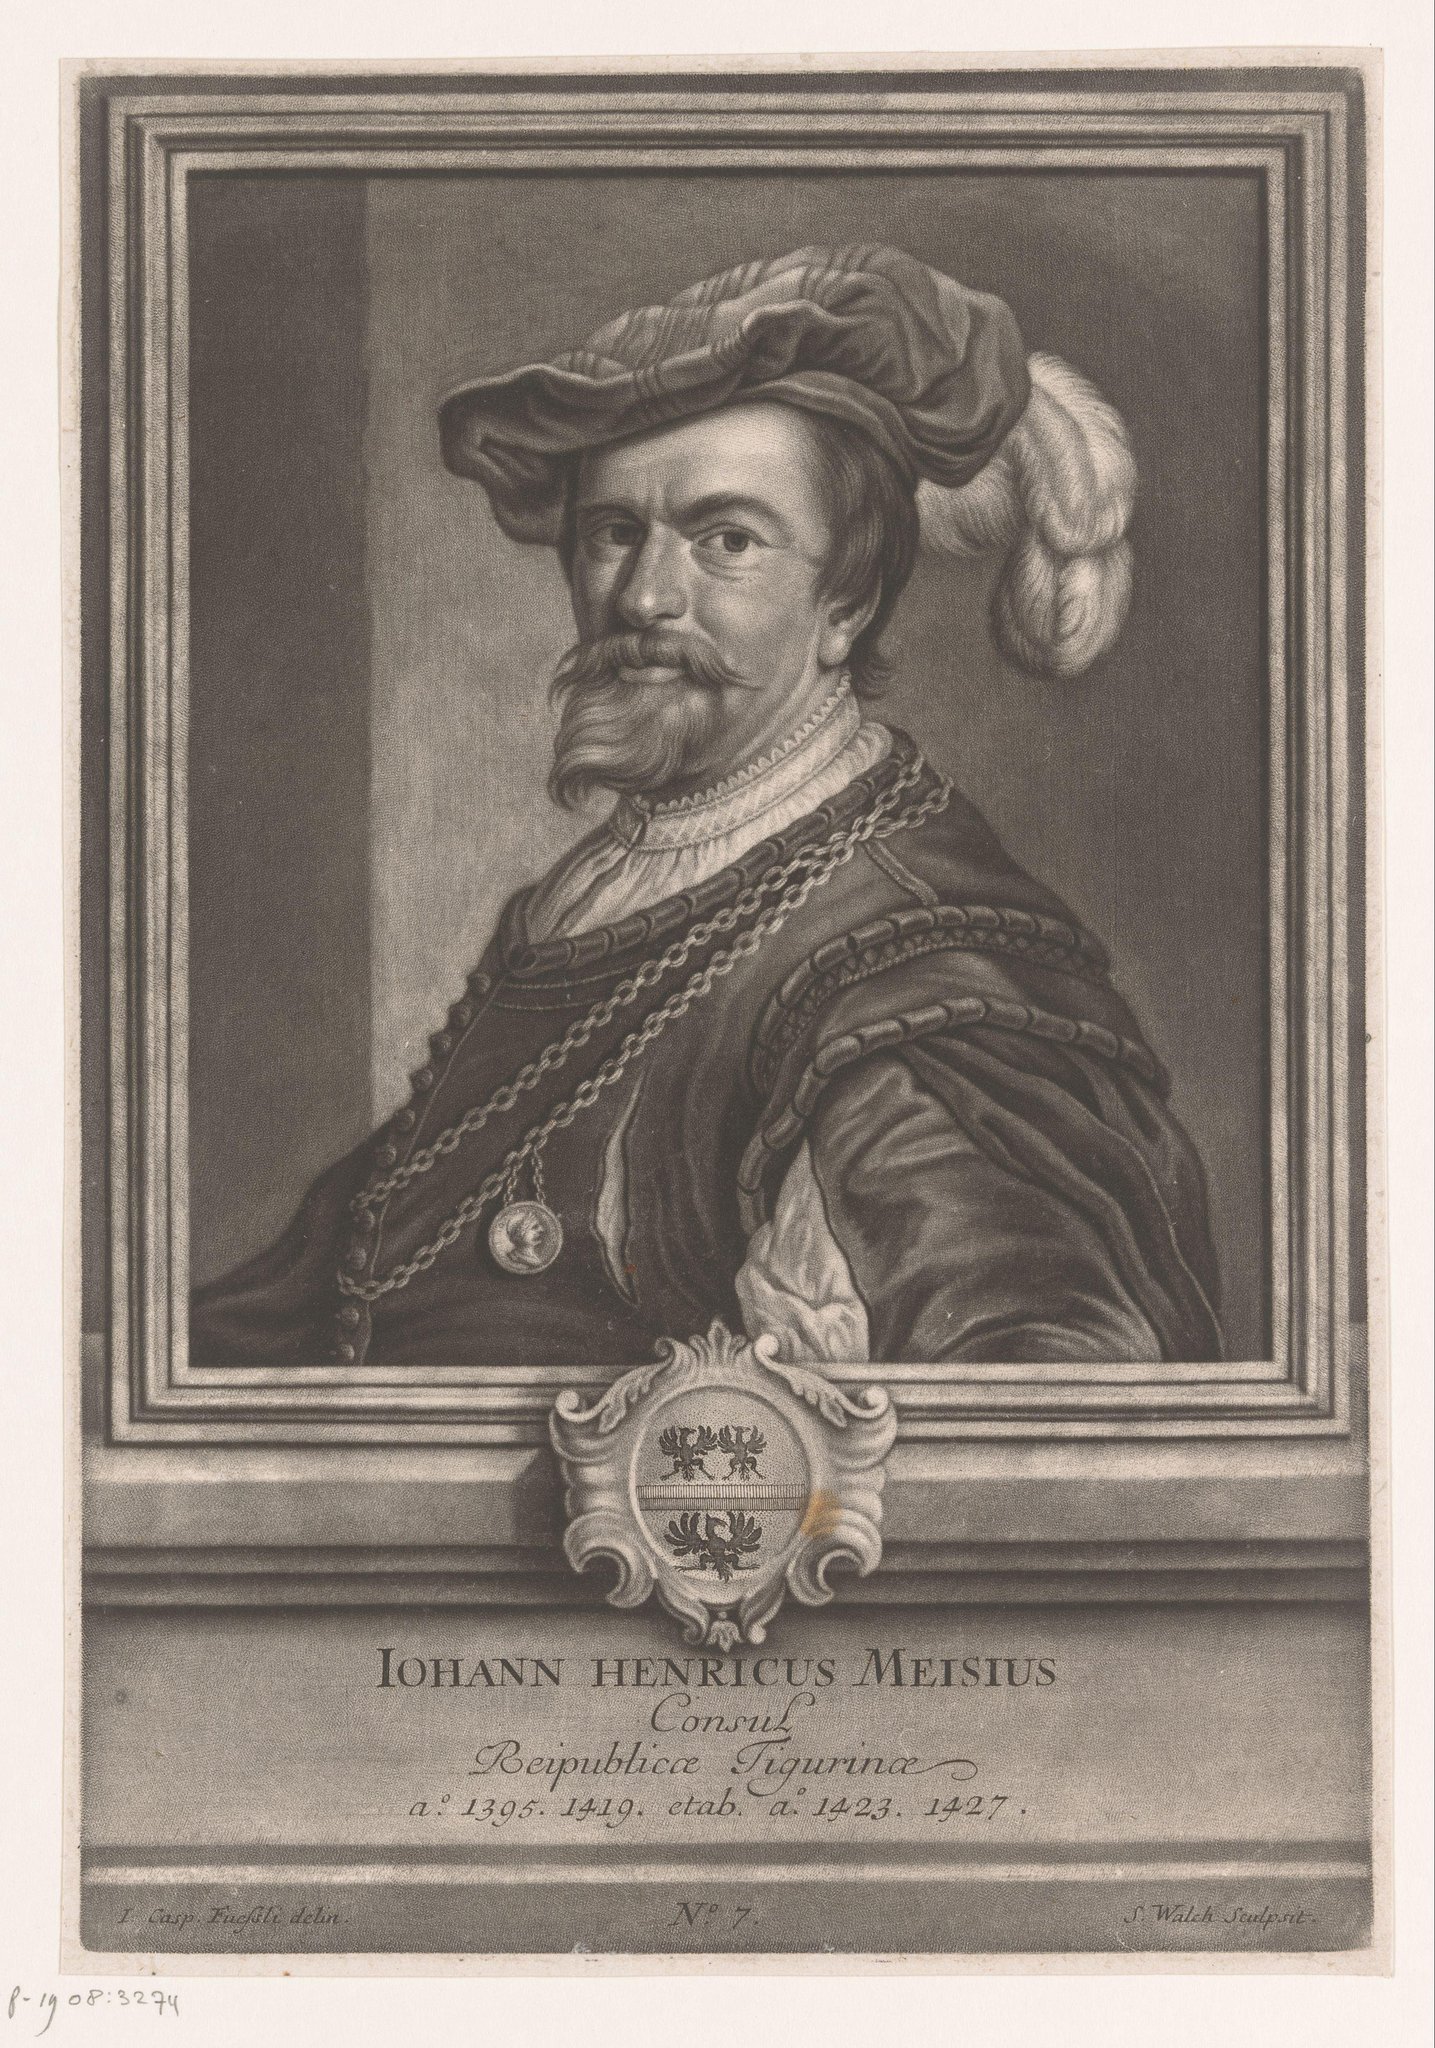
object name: print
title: Portret van Johannes Henricus Meisius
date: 1731-1788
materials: paper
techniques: mezzotint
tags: mayor, historical persons, armorial bearing, heraldry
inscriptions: collector's mark: Lugt 2228